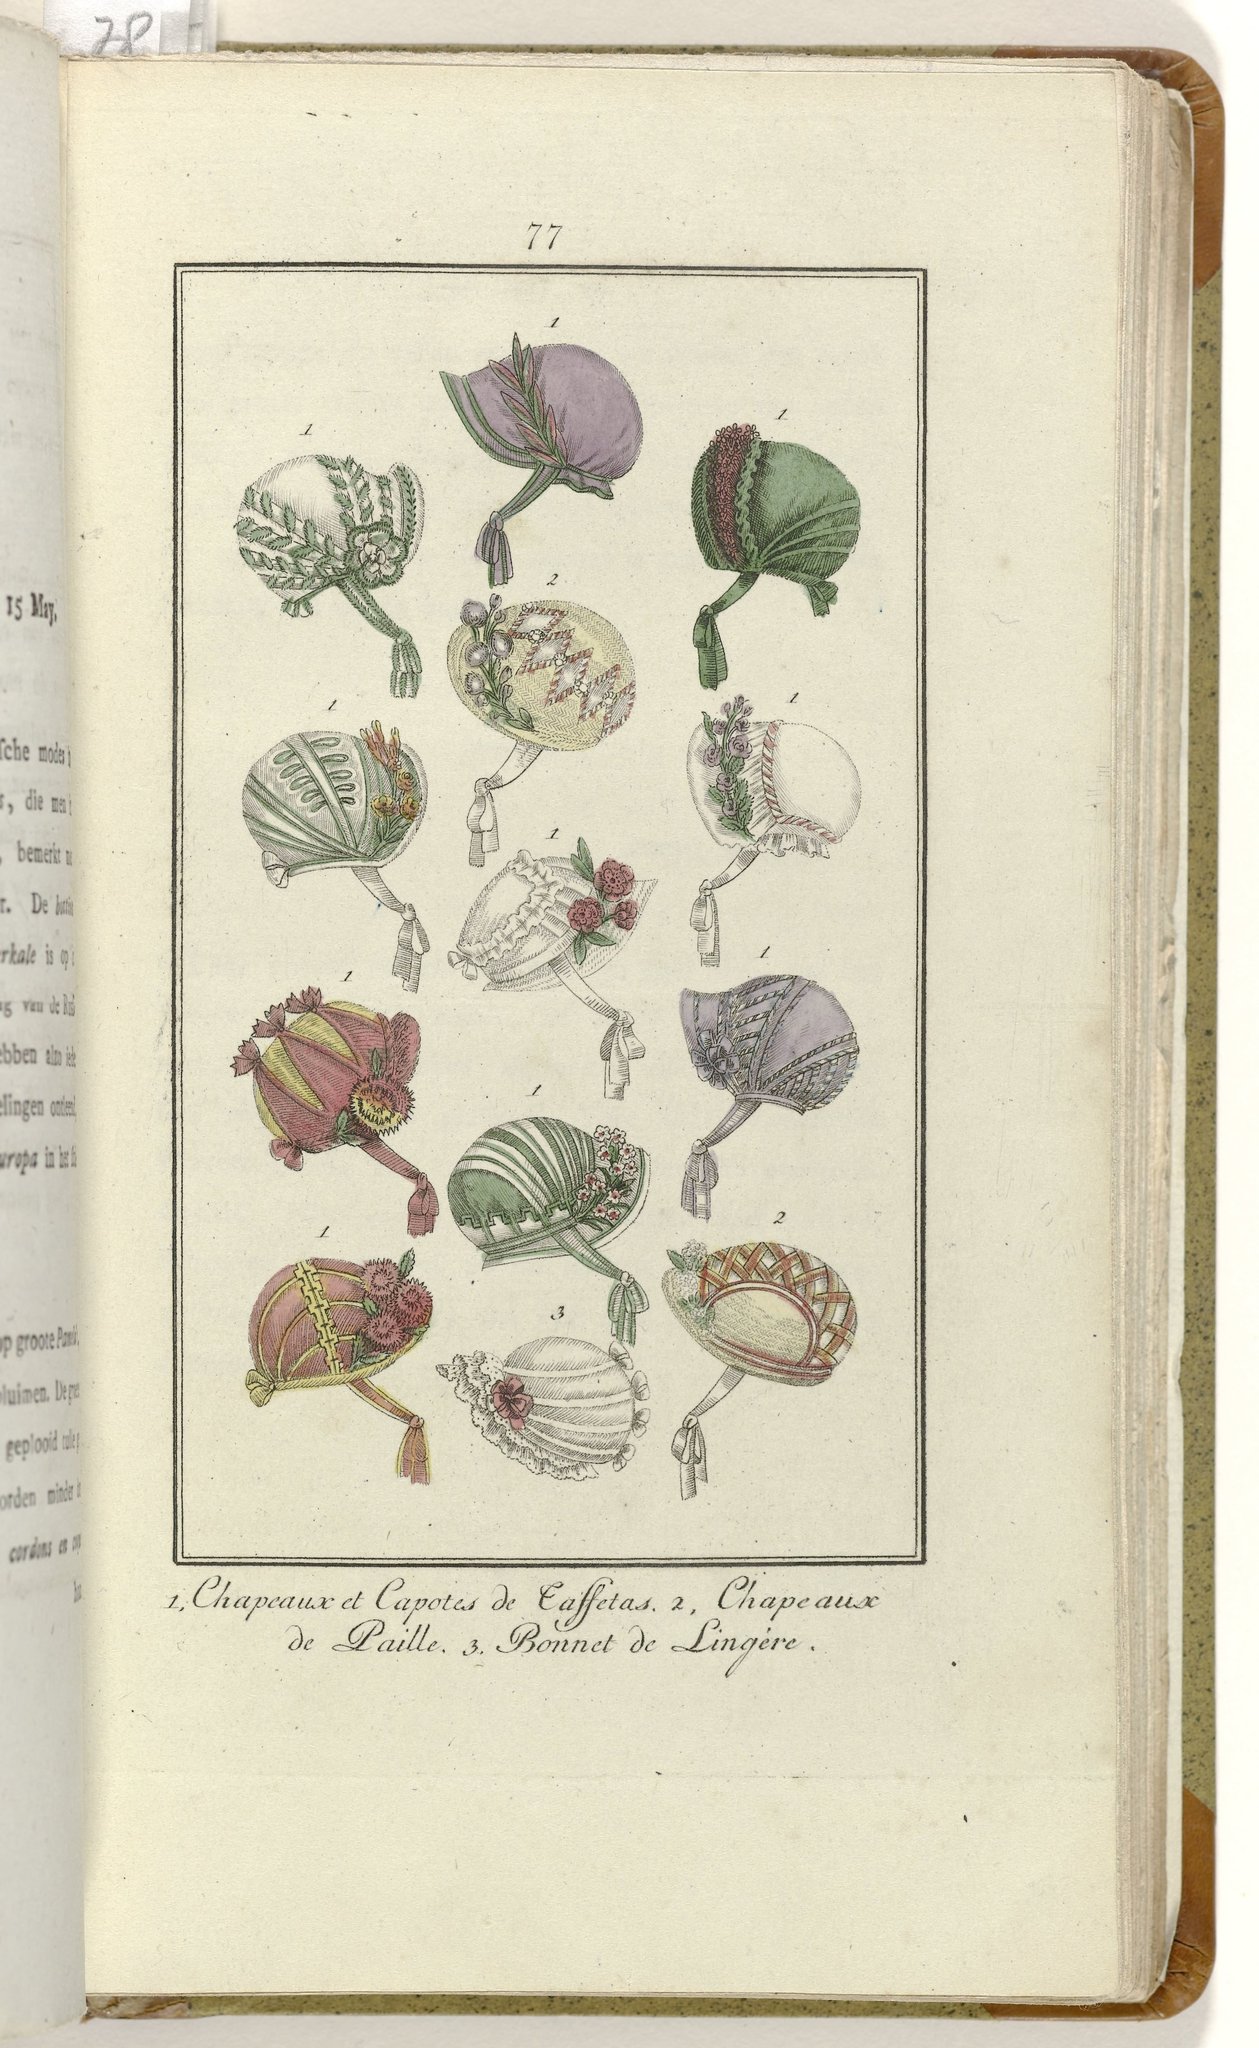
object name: magazine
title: Elegantia, of tijdschrift van mode, luxe en smaak voor dames, Mei 1809, No. 77: 1. Chapeaux et Capotes...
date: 1809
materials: paper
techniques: engraving, hand coloring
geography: amsterdam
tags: head-gear (capote) (+ women's clothes), head-gear: cap (+ women's clothes), fashion plates, head-gear: hat (+ women's clothes)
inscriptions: caption: ‘1. Chapeaux et Capotes de Taffetas. 2. Chapeaux de Paille. 3. Bonnet de Lingére.’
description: Volgens de begeleidende tekst (p. 159): Dertien verschillende modellen van zijden en strohoeden naar de 'nieuwsten smaak'. Volgens het onderschrift: 1. Hoeden en capotes van tafzijde. 2. Strohoeden. 3. 'Bonnet de lingére' (muts). Prent uit het modetijdschrift Elegantia, of tijdschrift van mode, luxe en smaak voor dames 1807-1814 (onderbroken door de periode 1811-1813).